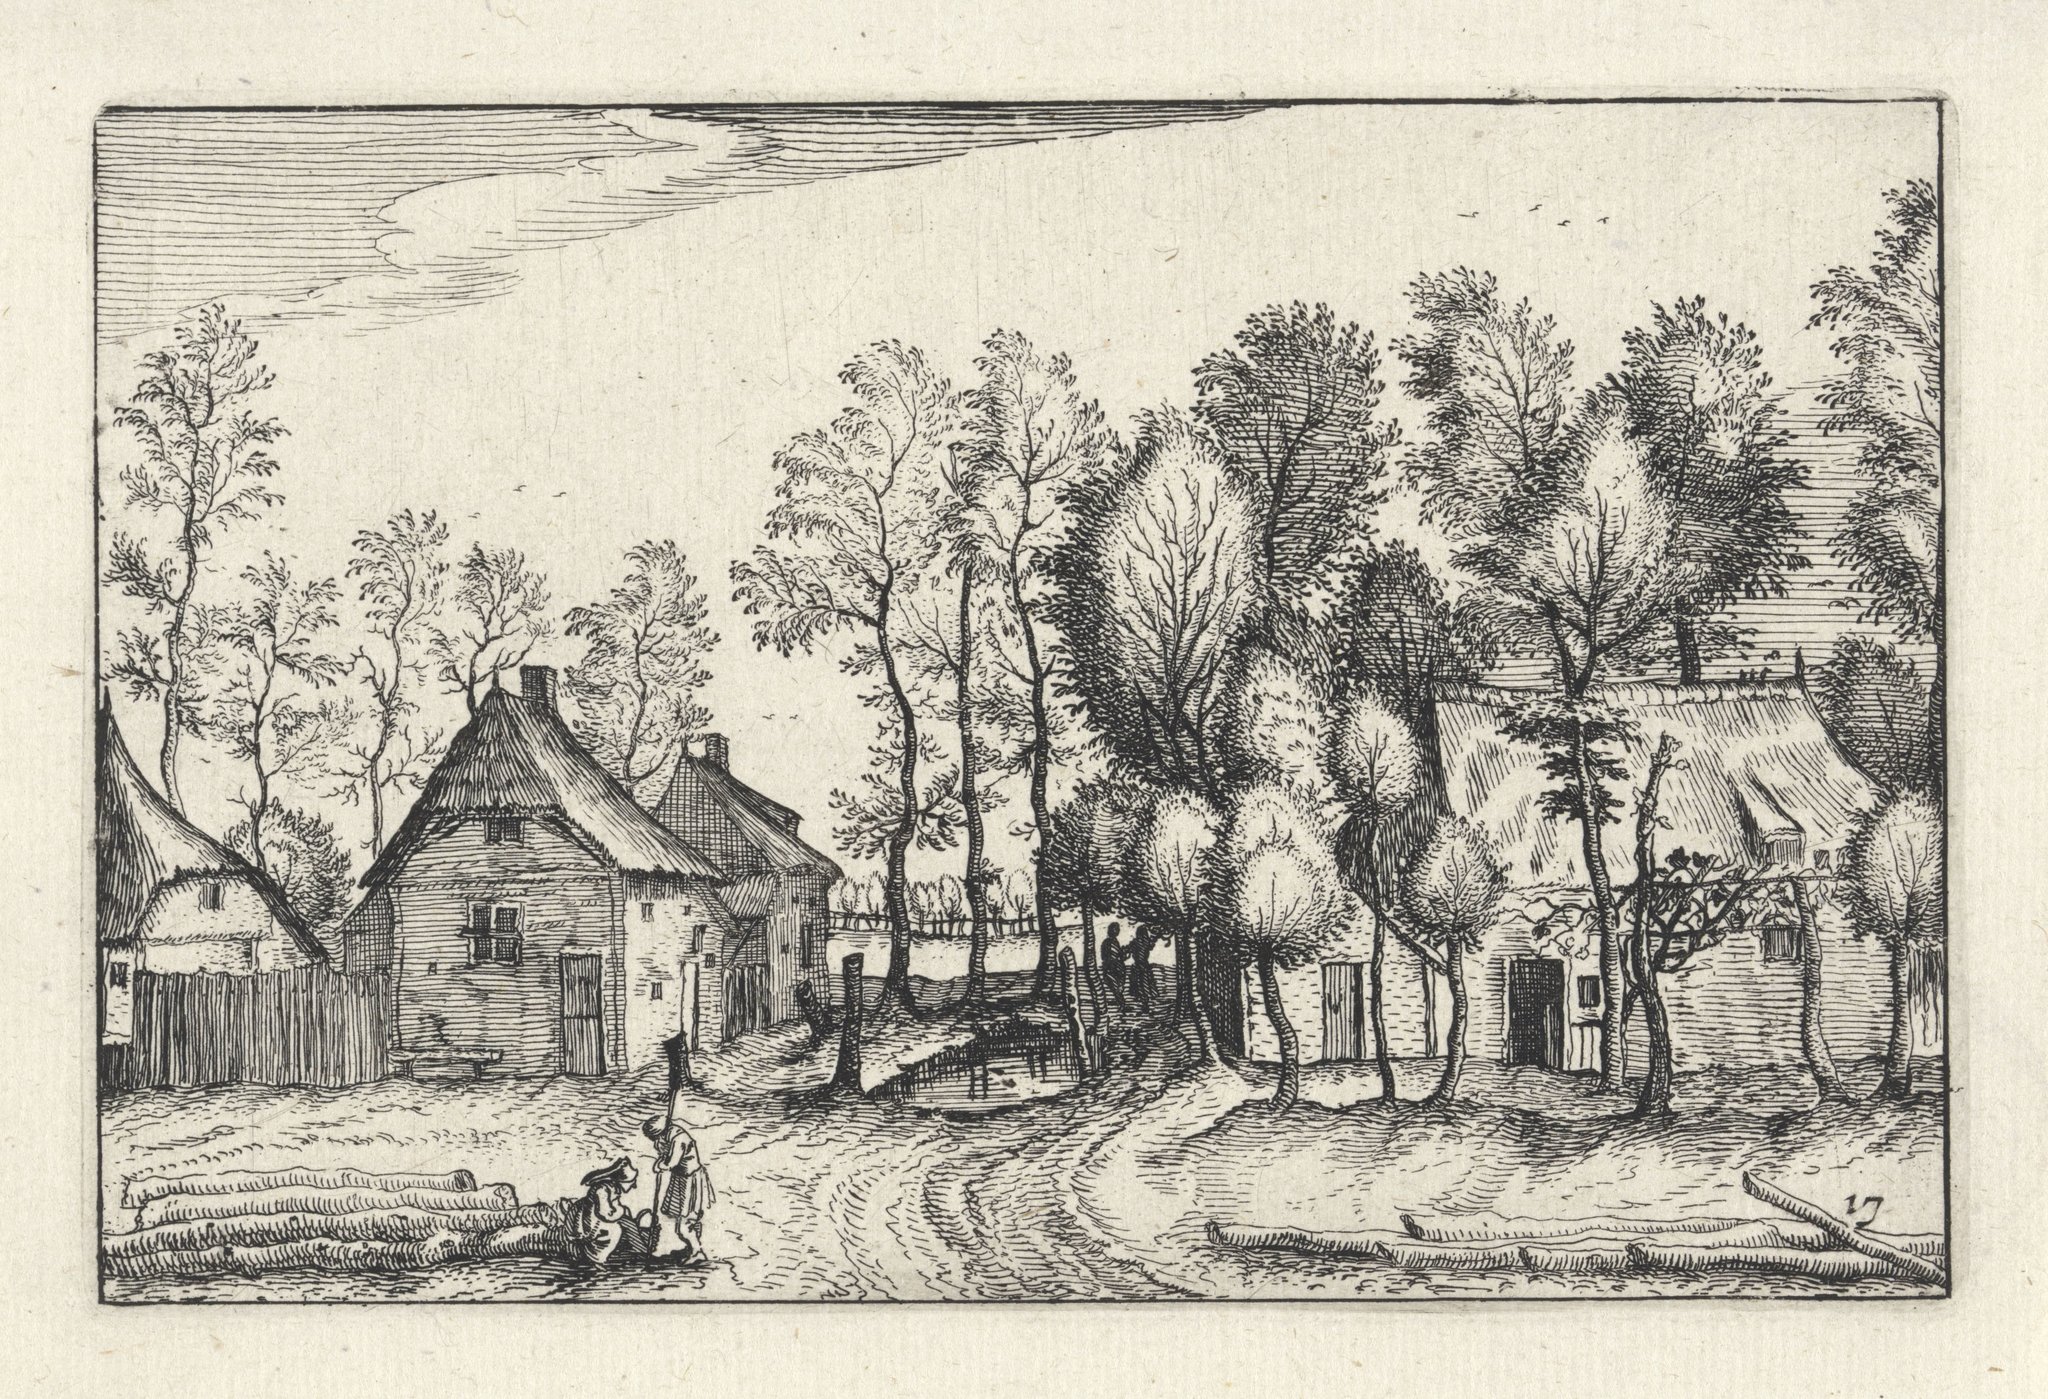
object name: print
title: Landschappen met gebouwen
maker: claes jansz. visscher (ii)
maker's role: draughtsman, print maker, publisher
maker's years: 1586-1652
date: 1620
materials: paper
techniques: etching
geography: amsterdam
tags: trees, road, path, farm or solitary house in landscape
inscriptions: collector's mark: Lugt 240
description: Gezicht op een landschap met in het midden een weg, met aan weerszijden gekapte bomen. Op de achtergrond liggen enkele huizen.